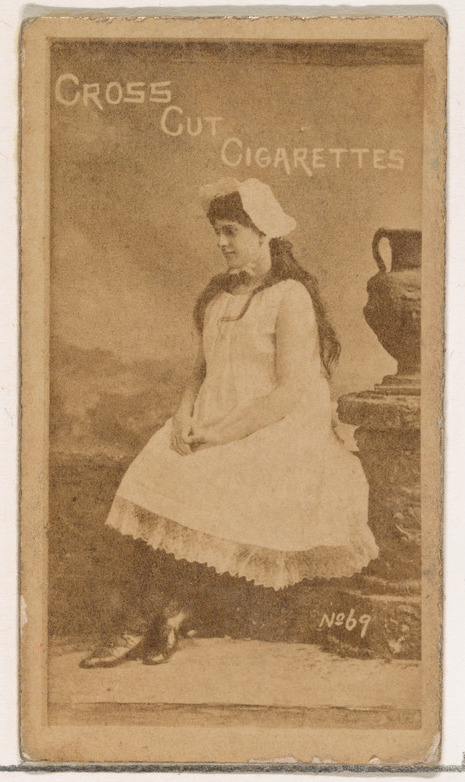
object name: print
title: Card Number 69, from the Actors and Actresses series (N145-1) issued by Duke Sons & Co. to promote Cross Cut Cigarettes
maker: w. duke, sons & co.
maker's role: publisher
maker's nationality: american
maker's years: 1870-1920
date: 1880-1889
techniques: albumen silver print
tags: women,actresses